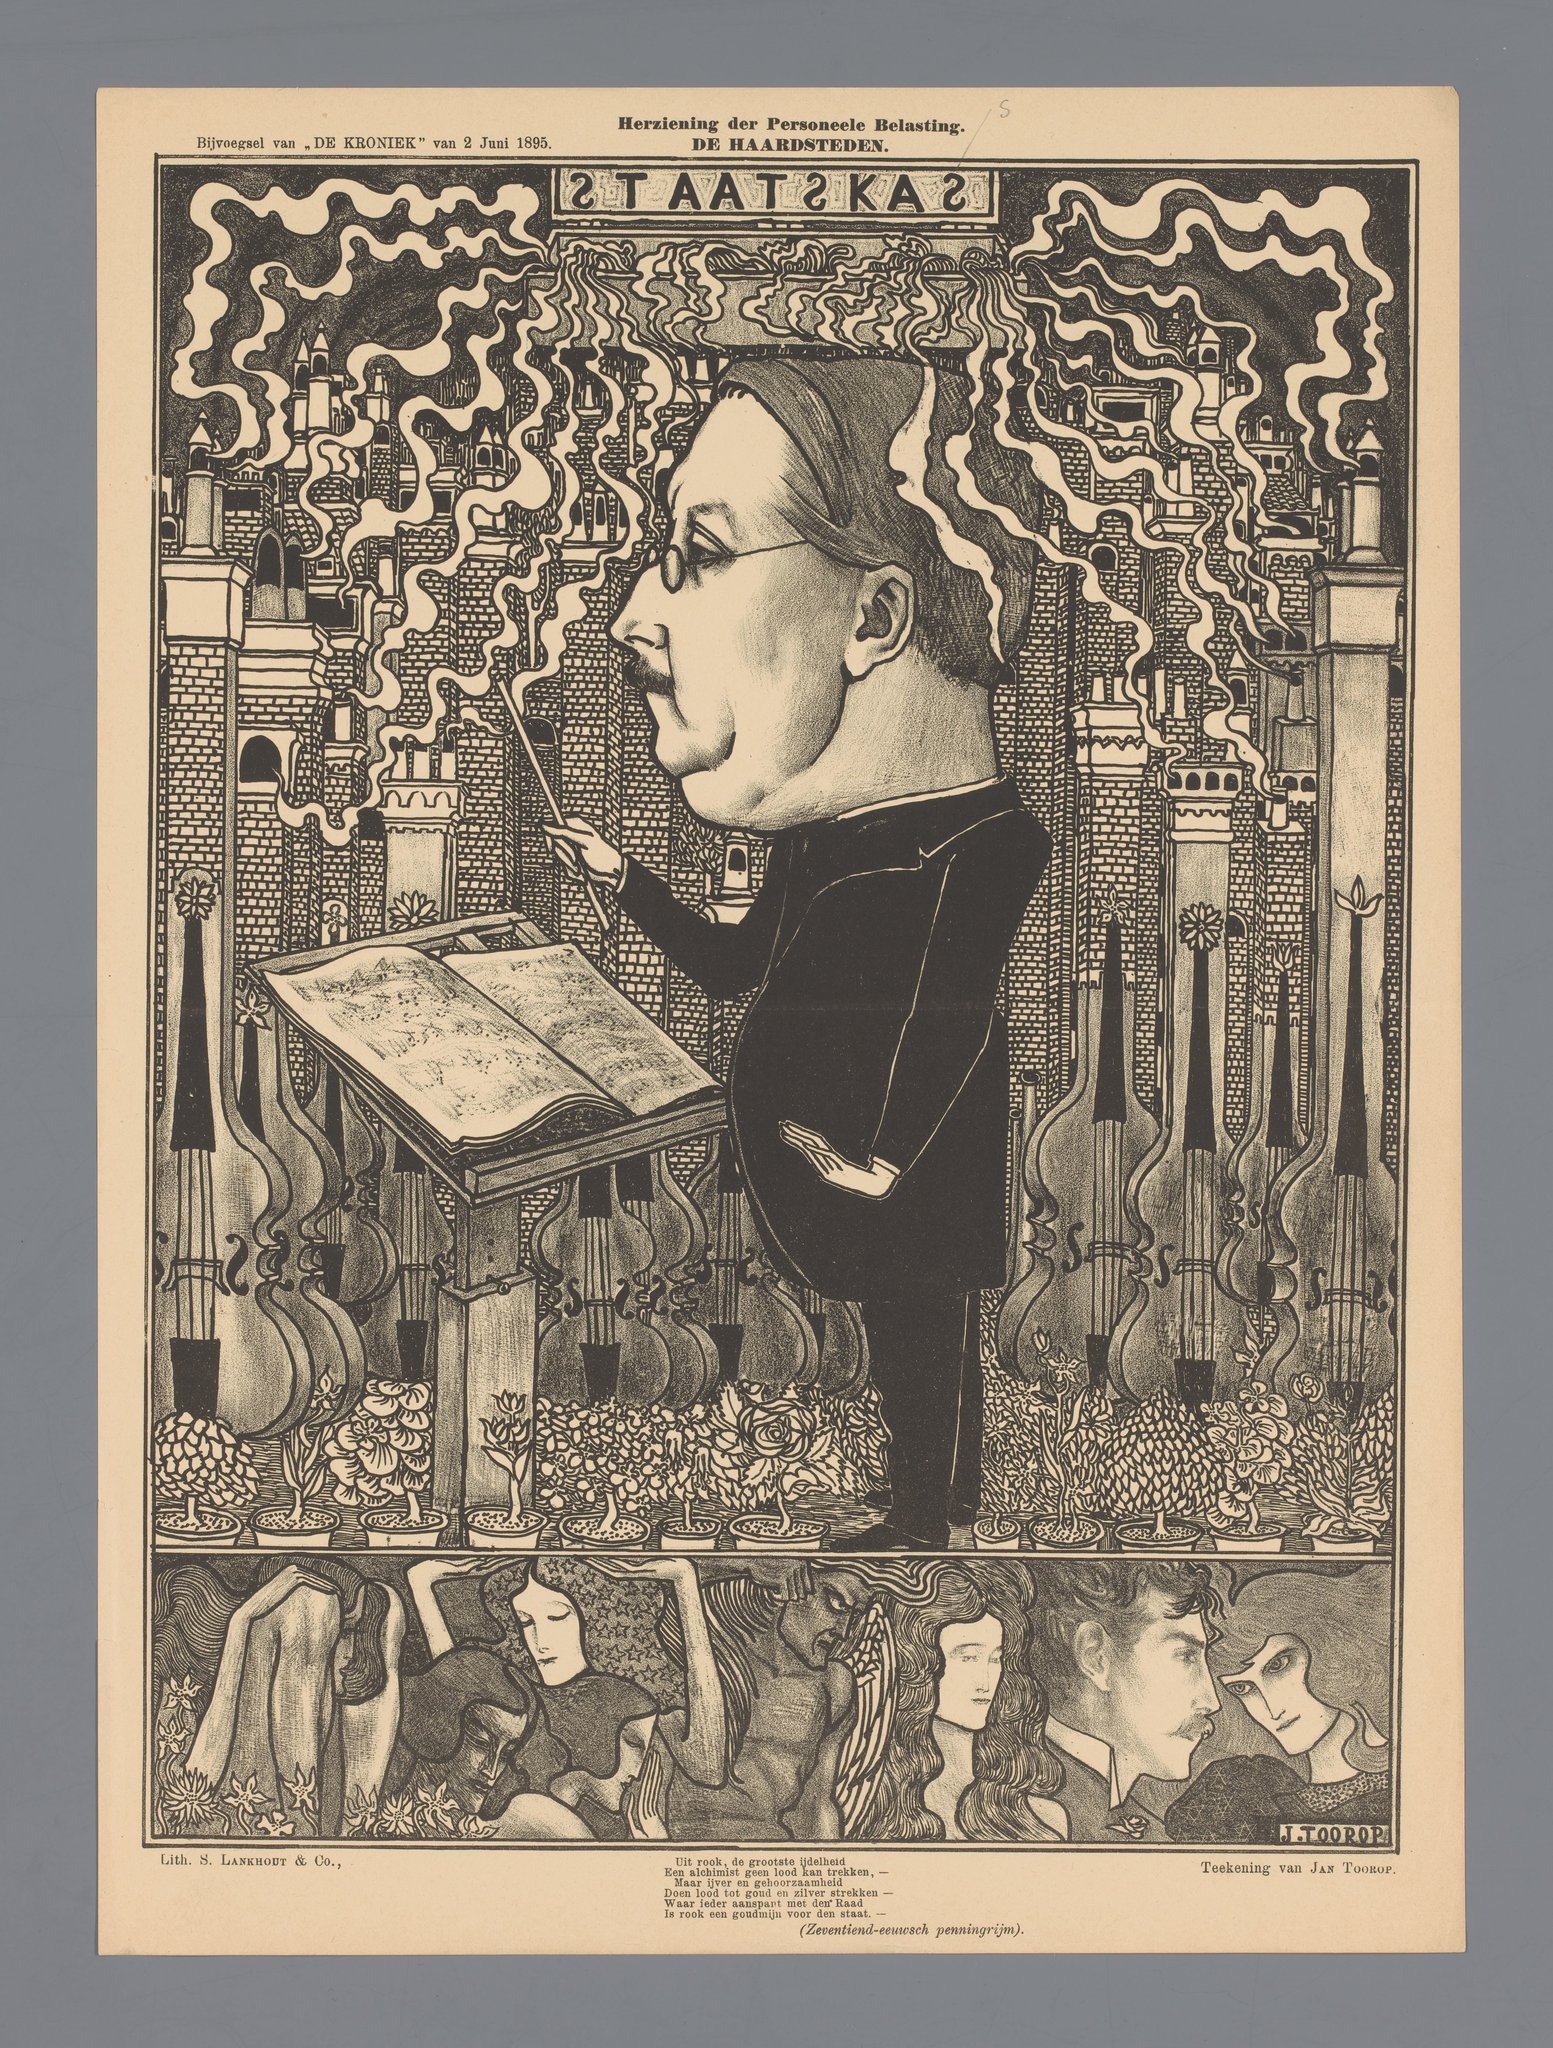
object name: print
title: Herziening der Personeele Belasting. De Haardsteden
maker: jan toorop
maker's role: draughtsman, painter, print maker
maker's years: 1858-1928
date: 1895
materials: paper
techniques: lithograph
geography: the hague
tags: chimney, minister ~ government, historical persons, political caricatures and satires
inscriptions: date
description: Prent uit het bijvoegsel van: De Kroniek 1 (1895), 2 juni 1895.